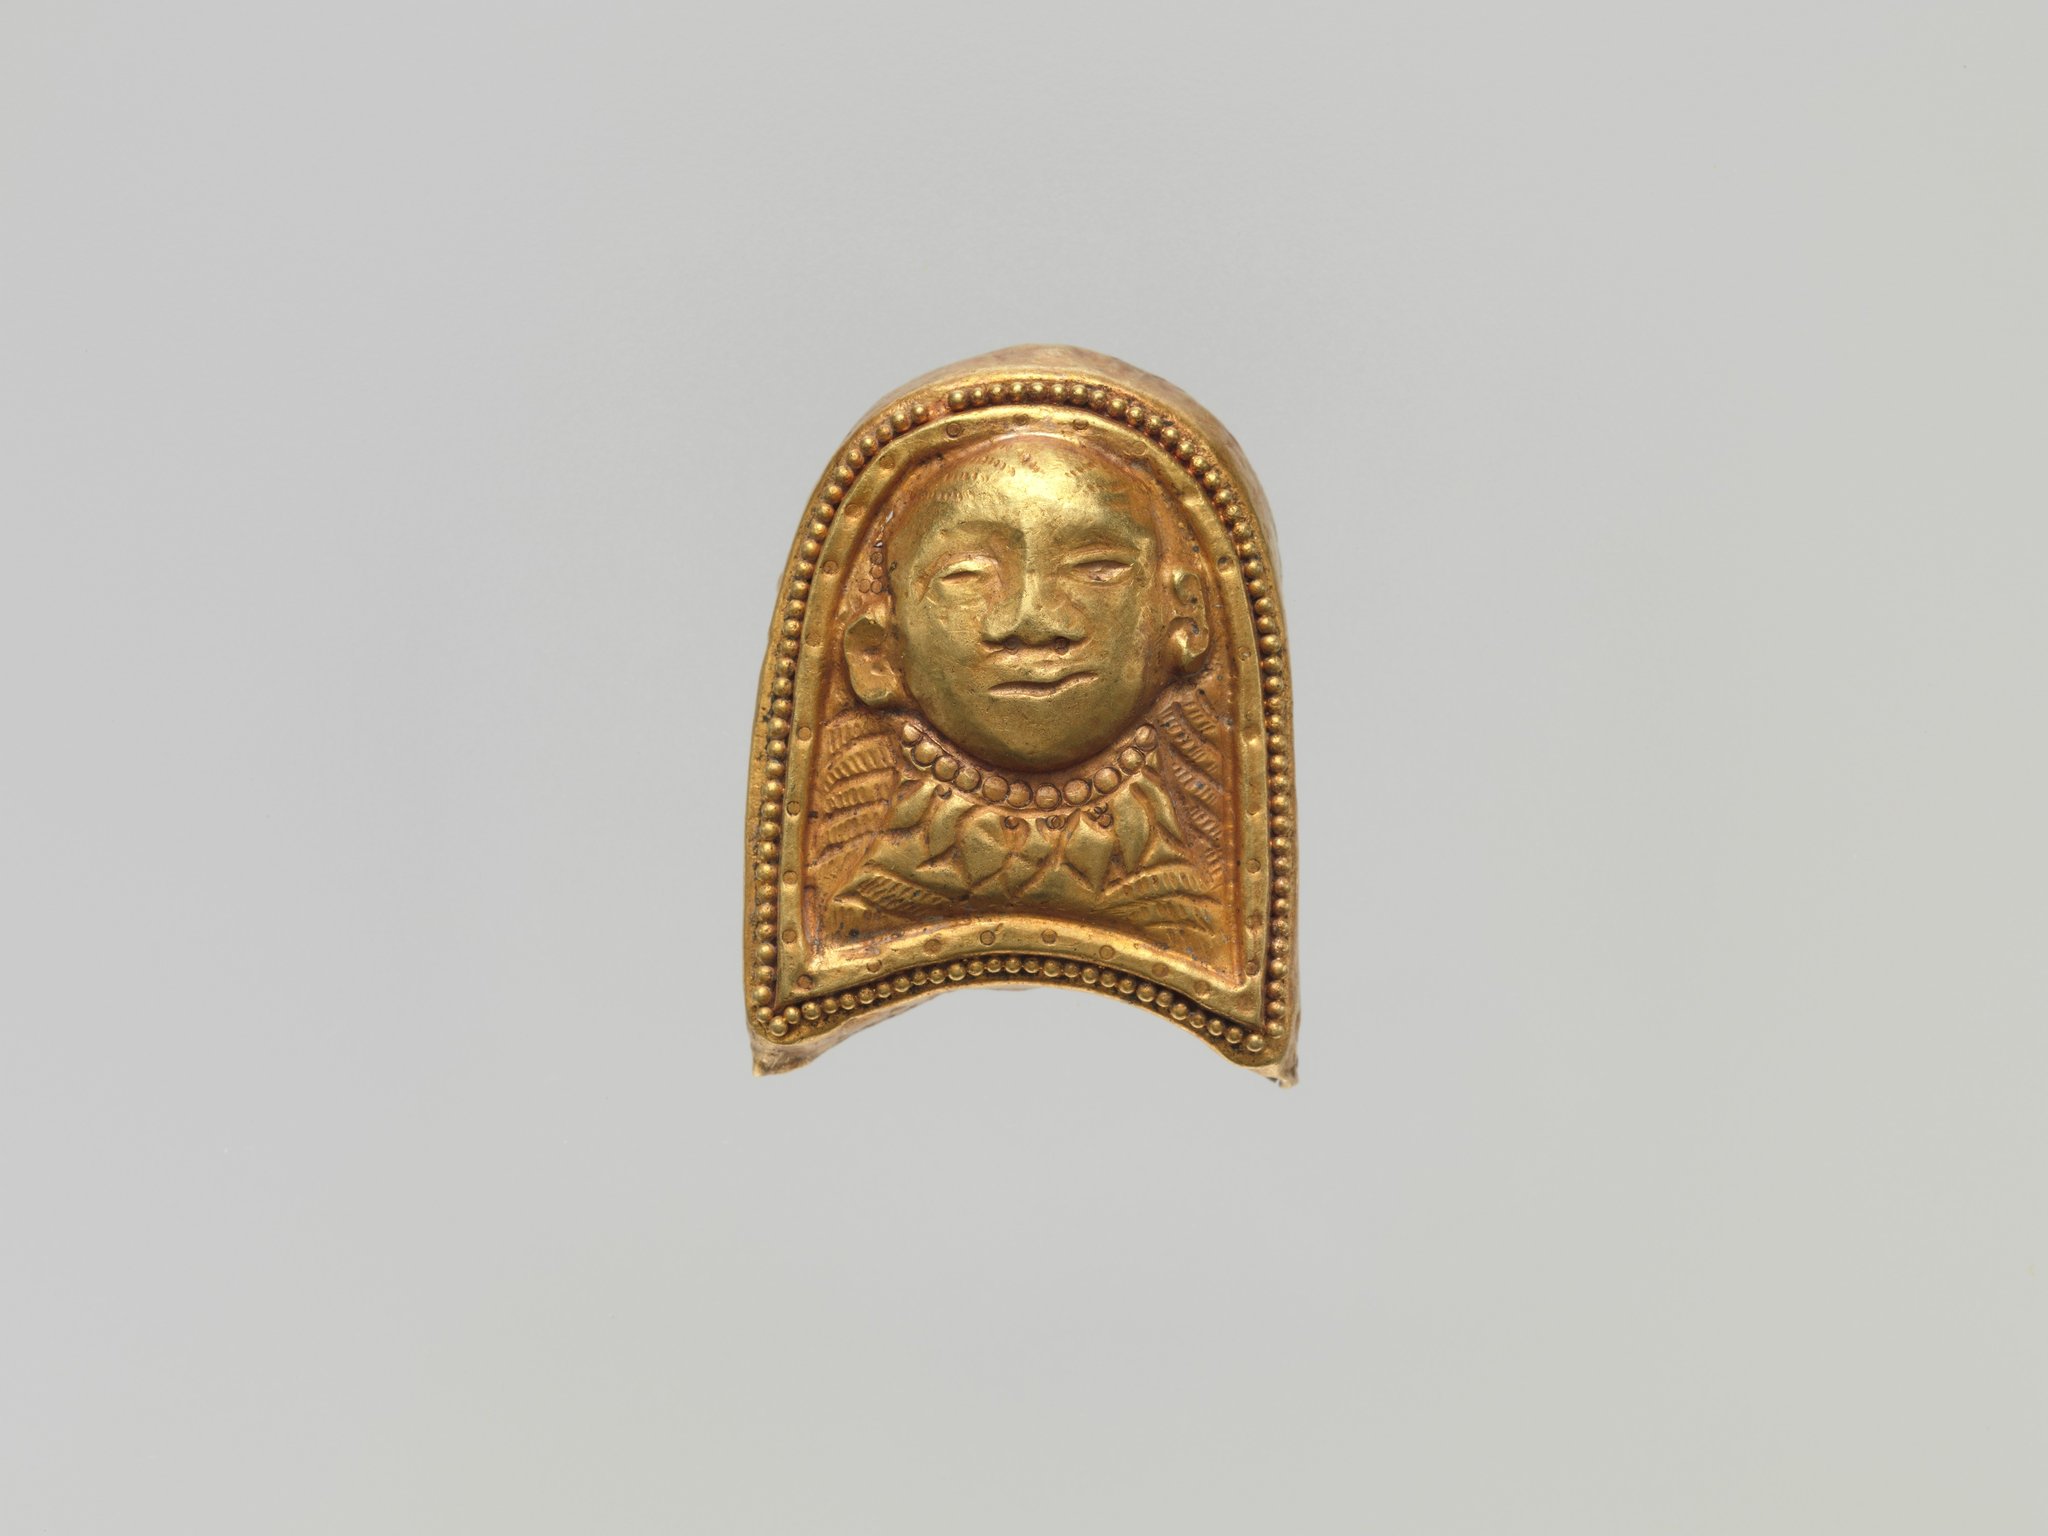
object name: plaque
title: Plaque with Head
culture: chinese or central asian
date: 601-900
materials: gold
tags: heads